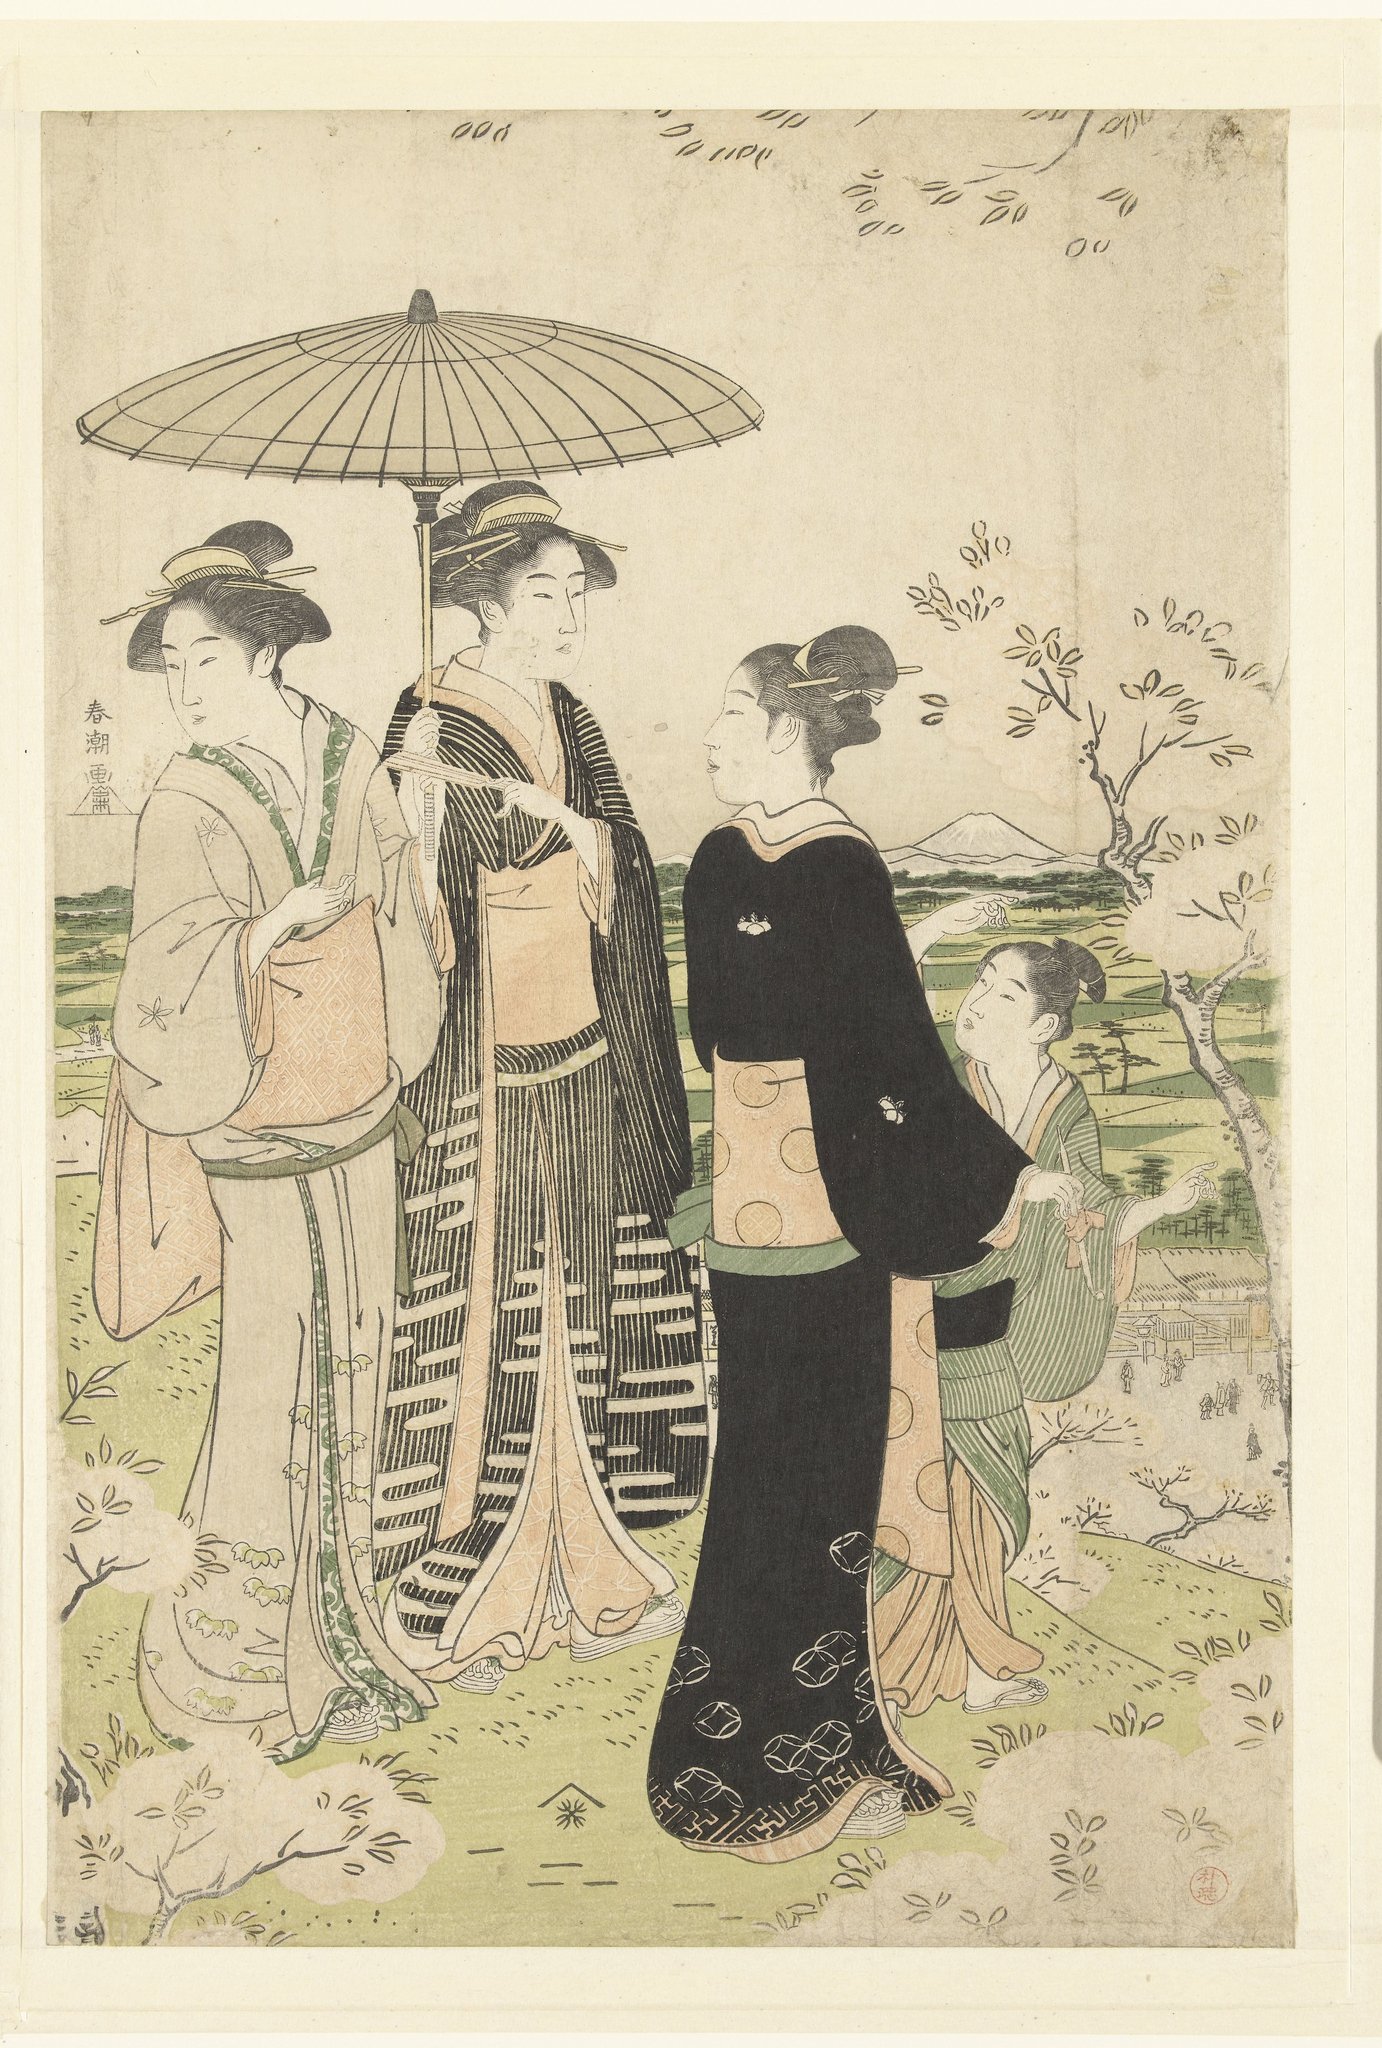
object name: print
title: Bewonderen van de kersenbloesem te Asukayama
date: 1785-1790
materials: paper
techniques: woodcut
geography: japan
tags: adult woman (+ three persons), landscapes (+ landscape with figures, staffage), parasol, sunshade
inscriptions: collector's mark: Lugt 2971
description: Drie vrouwen, waarvan twee onder parasol, en een jongetje wandelend tussen bloesemende kersenbomen; op de achtergrond de berg Fuji.